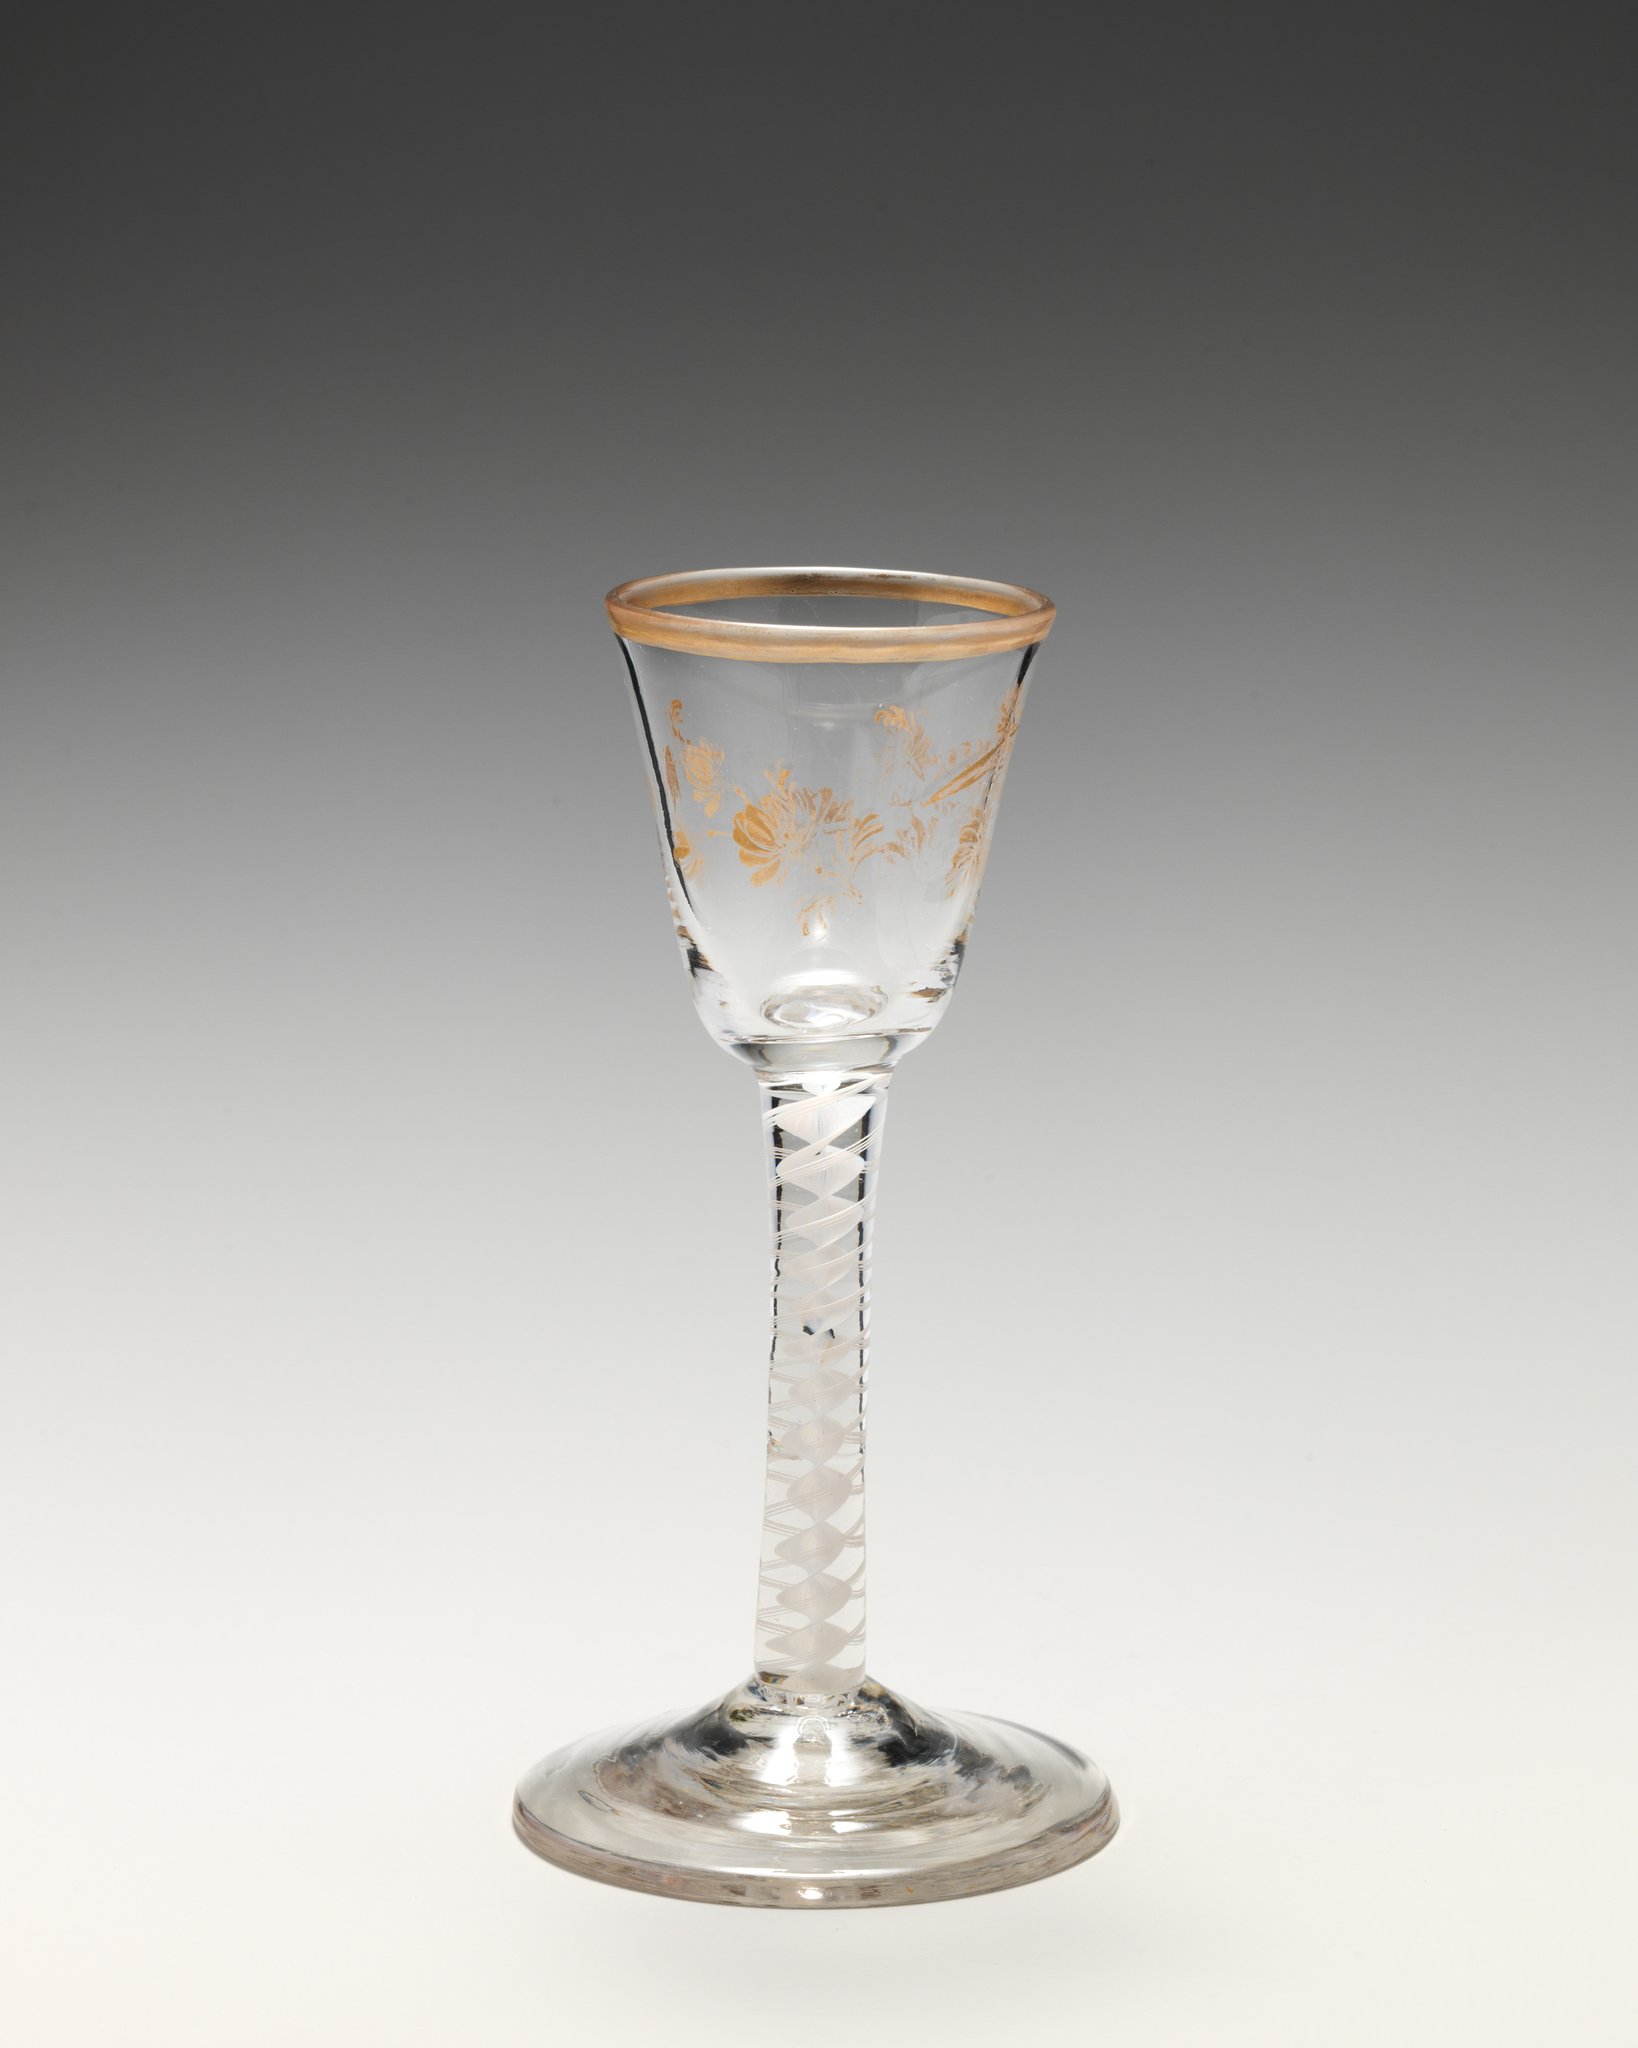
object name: wineglass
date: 1750-1800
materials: glass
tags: flowers